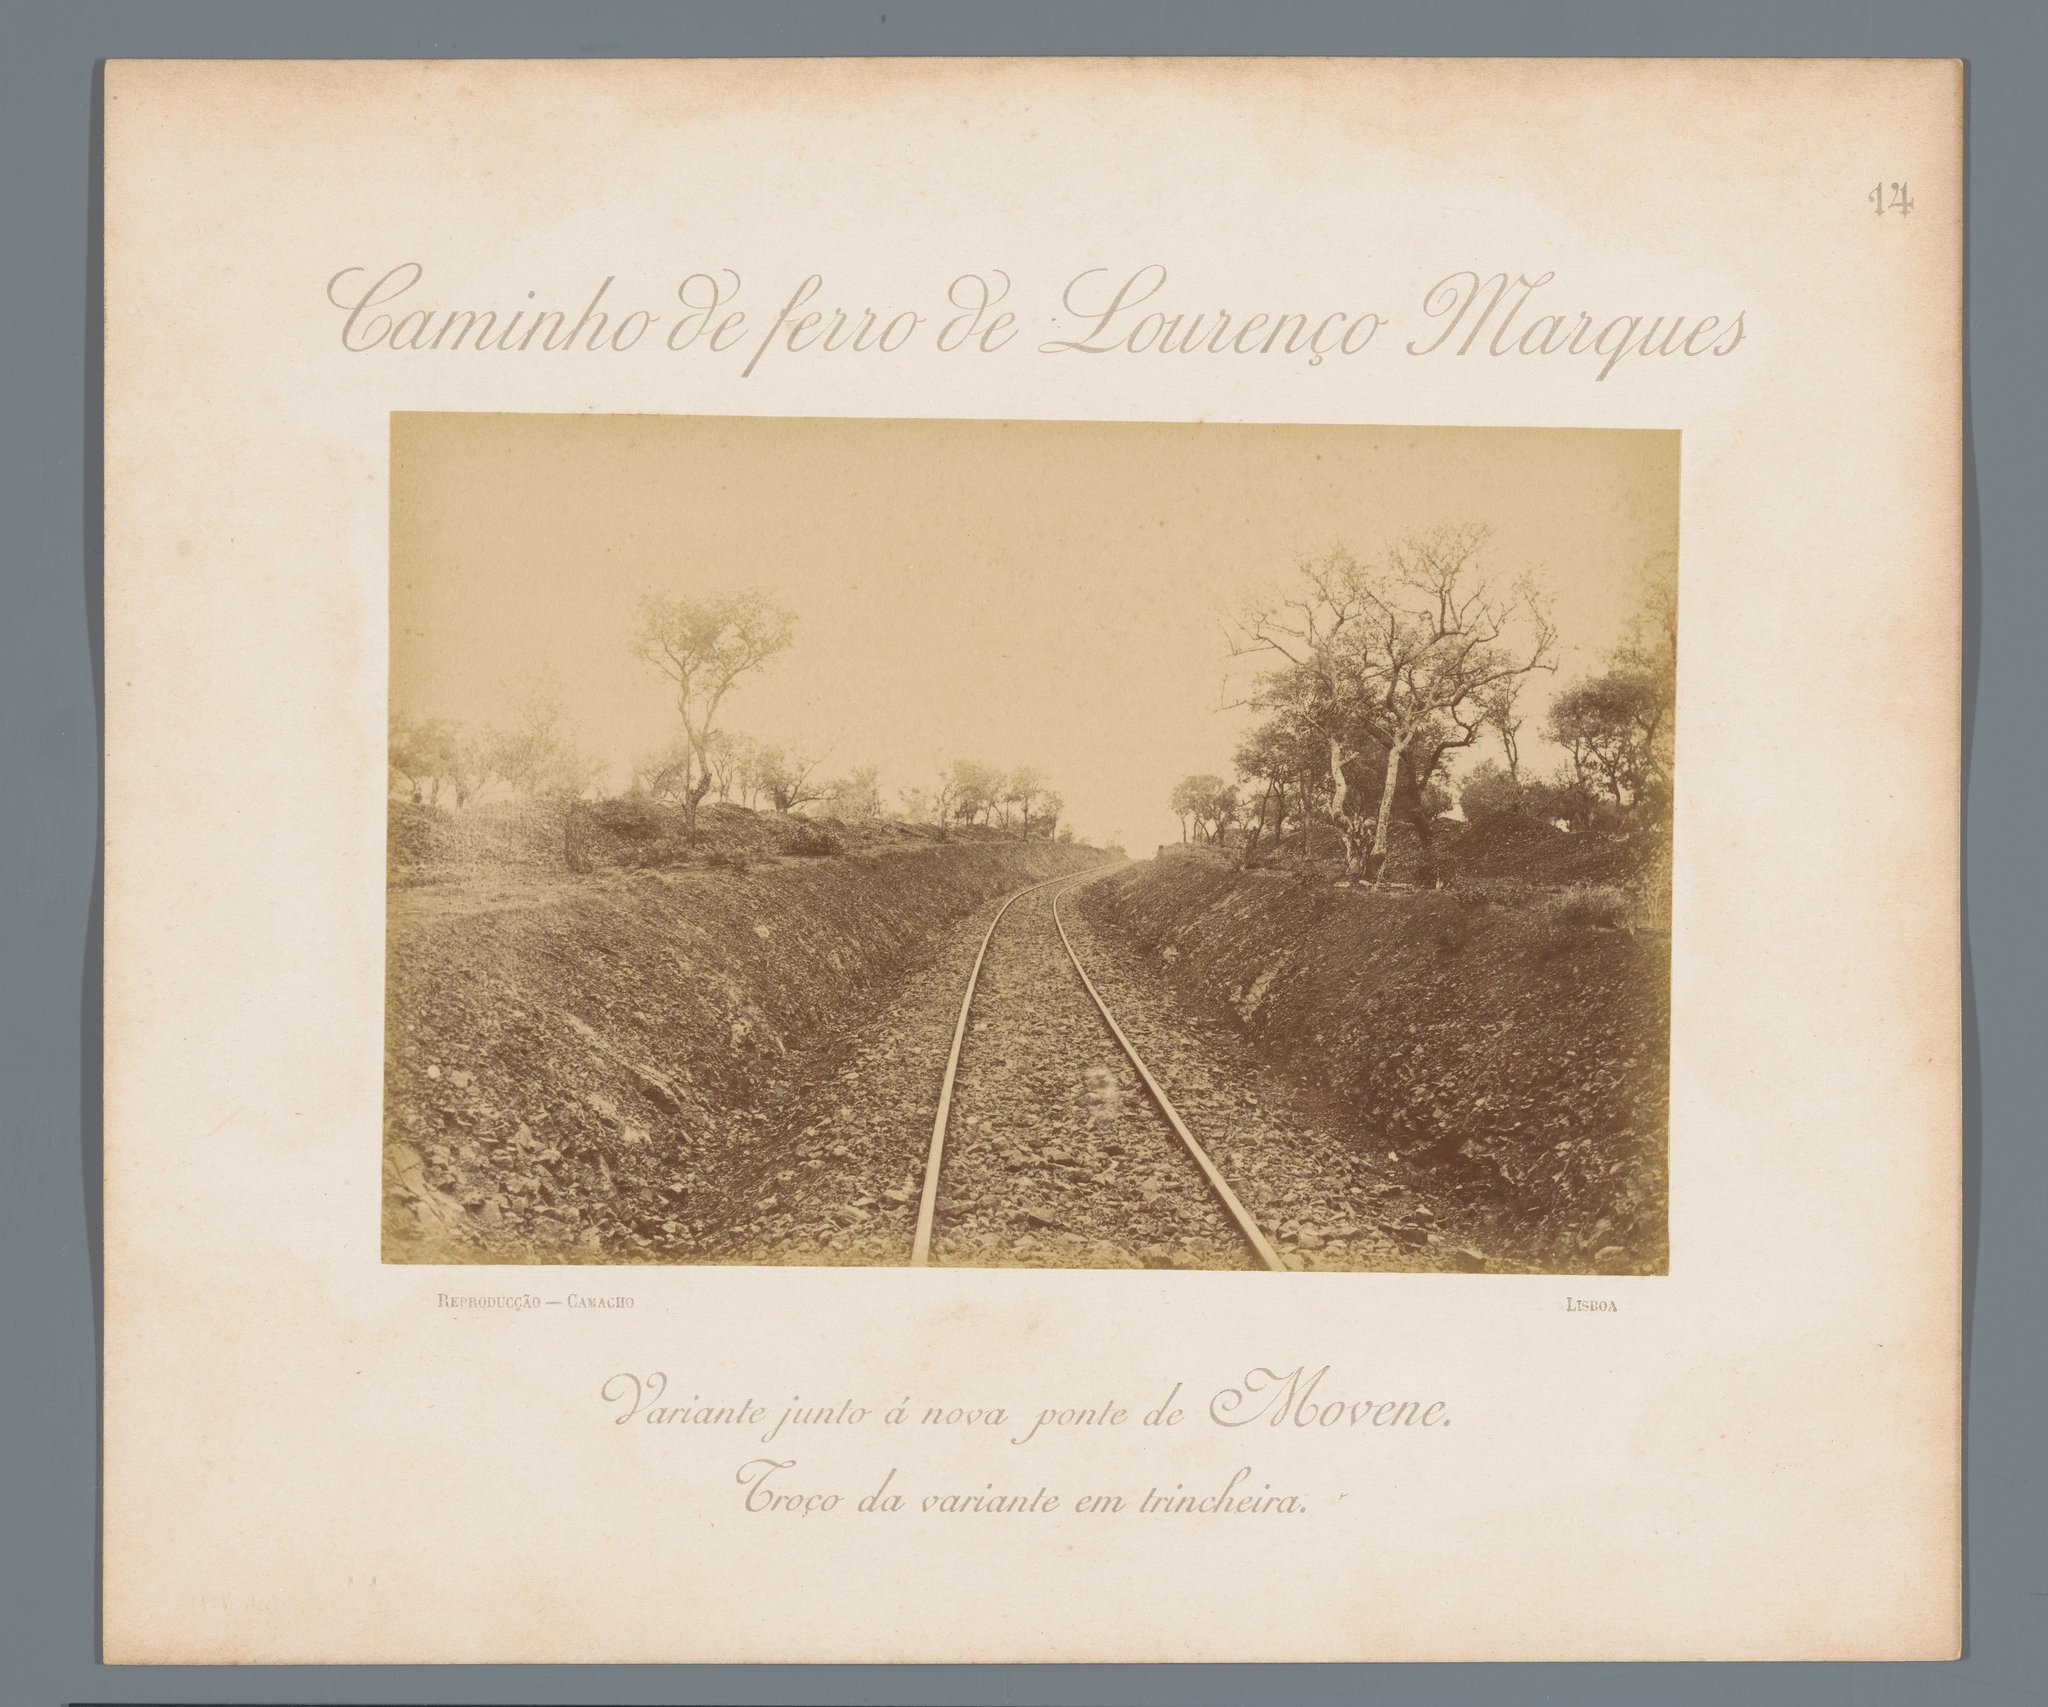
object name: page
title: Treinspoor in de buurt van de brug over de Rio Movene in Mozambique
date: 1889-1895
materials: photographic support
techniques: albumen print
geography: mozambique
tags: railway, train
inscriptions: number: ‘14’